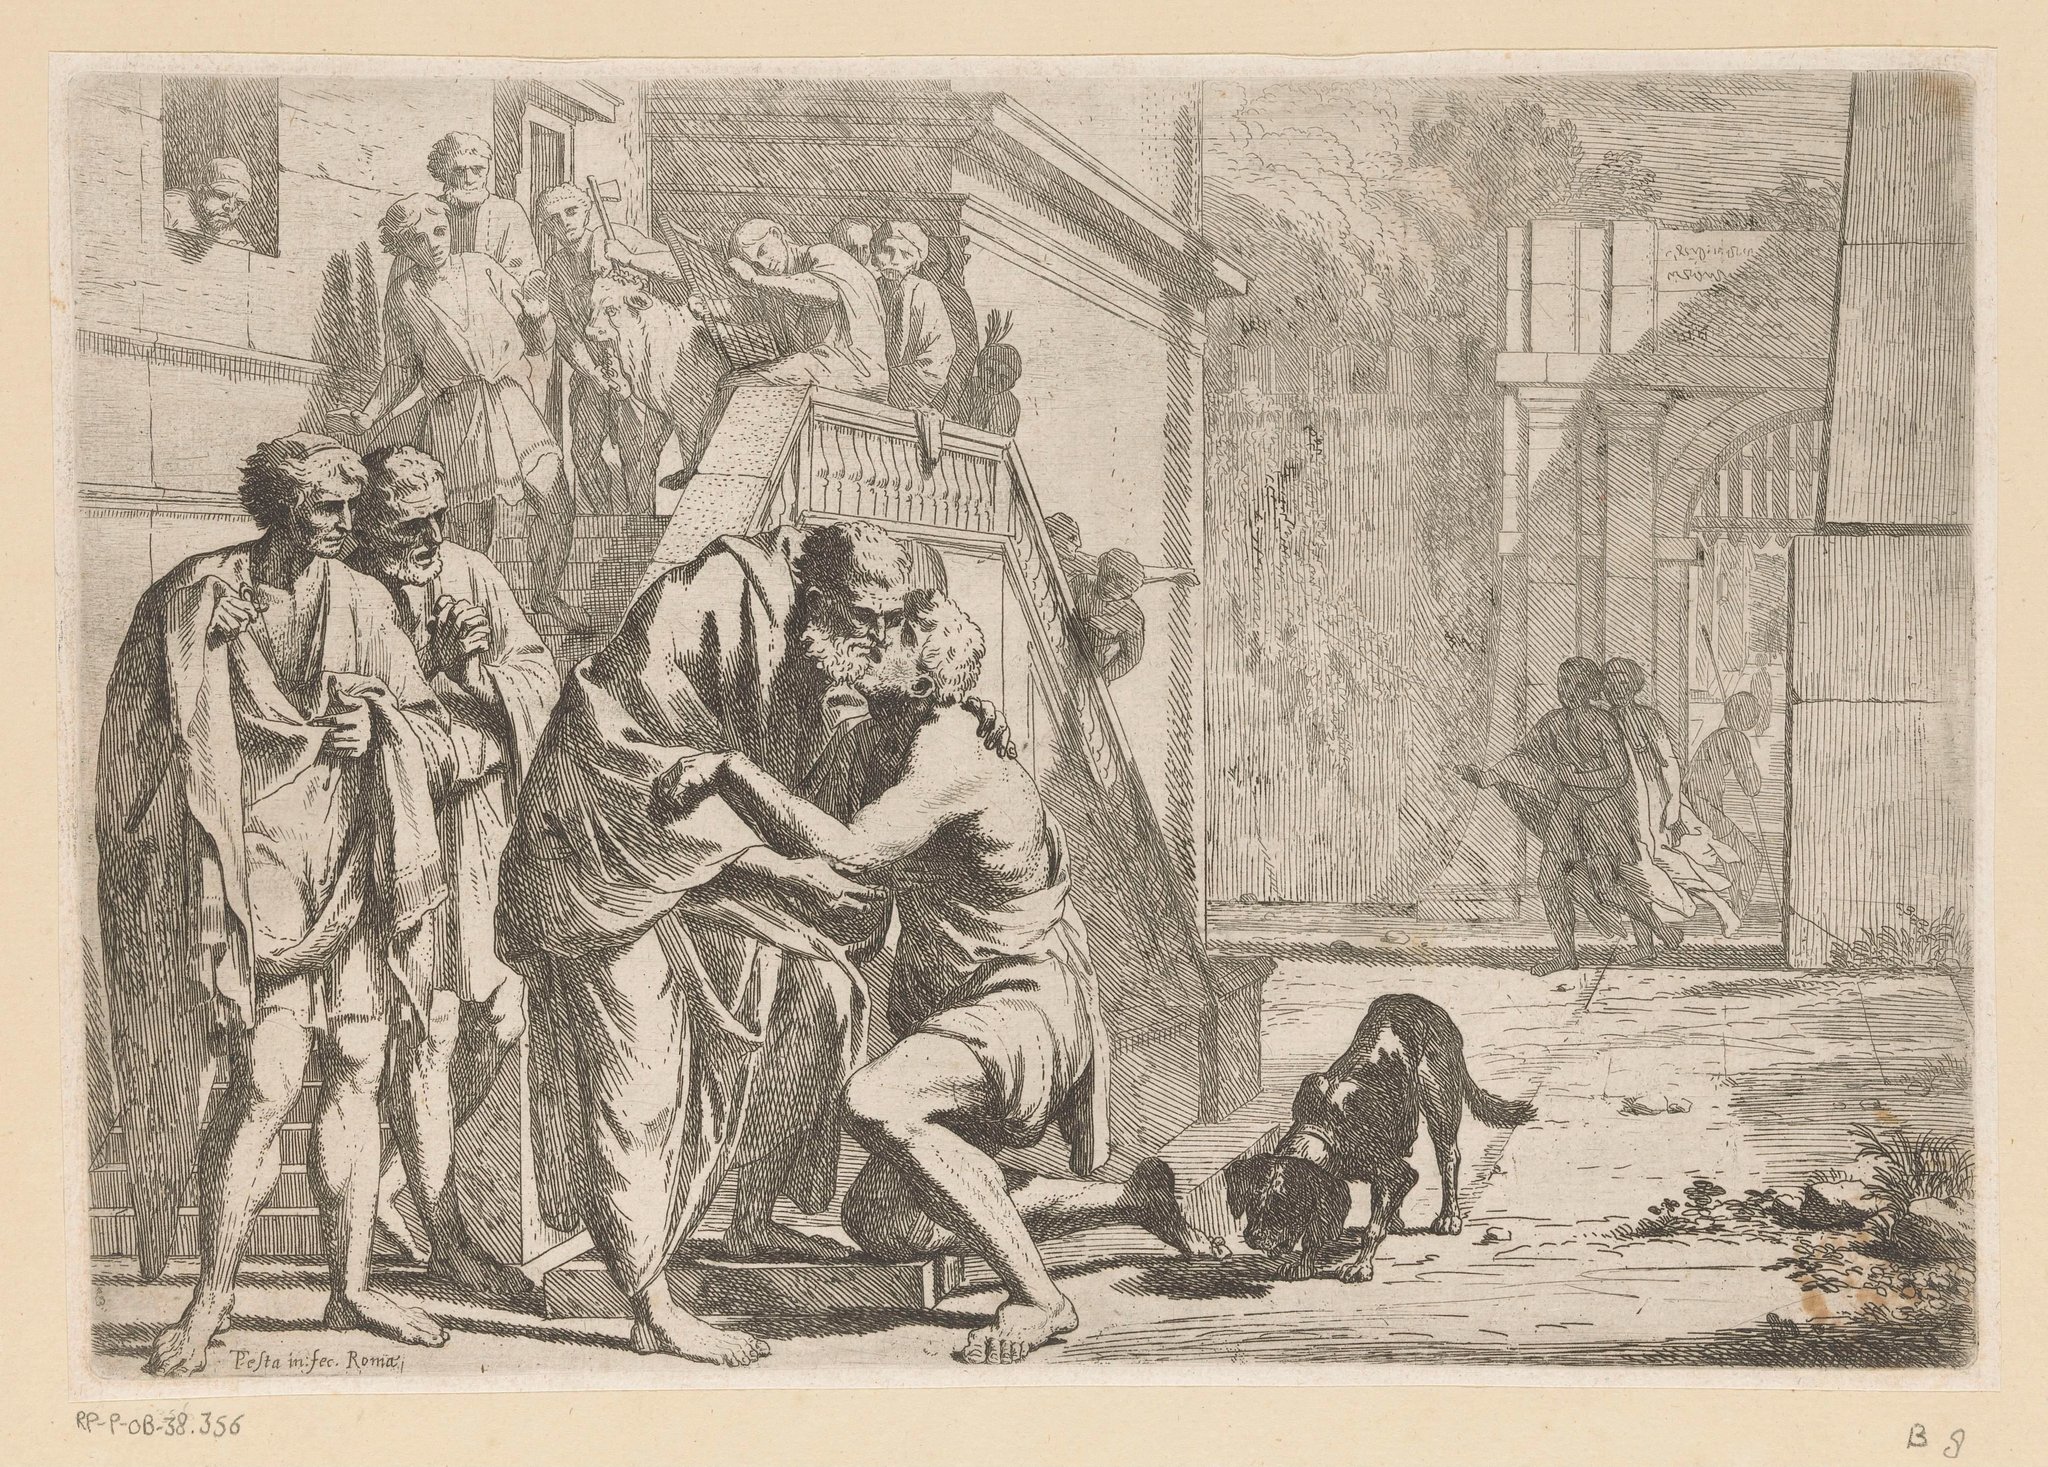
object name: print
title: Verhaal van de verloren zoon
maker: pietro testa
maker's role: draughtsman, painter, print maker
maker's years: 1611-1650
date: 1621-1650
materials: paper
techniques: etching, intaglio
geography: rome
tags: the prodigal son returns home, where his father awaits him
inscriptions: collector's mark: Lugt 240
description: De verloren zoon knielt voor zijn vader en wordt door hem omhelsd. Links twee toekijkende mannen en een groep figuren op een trap.